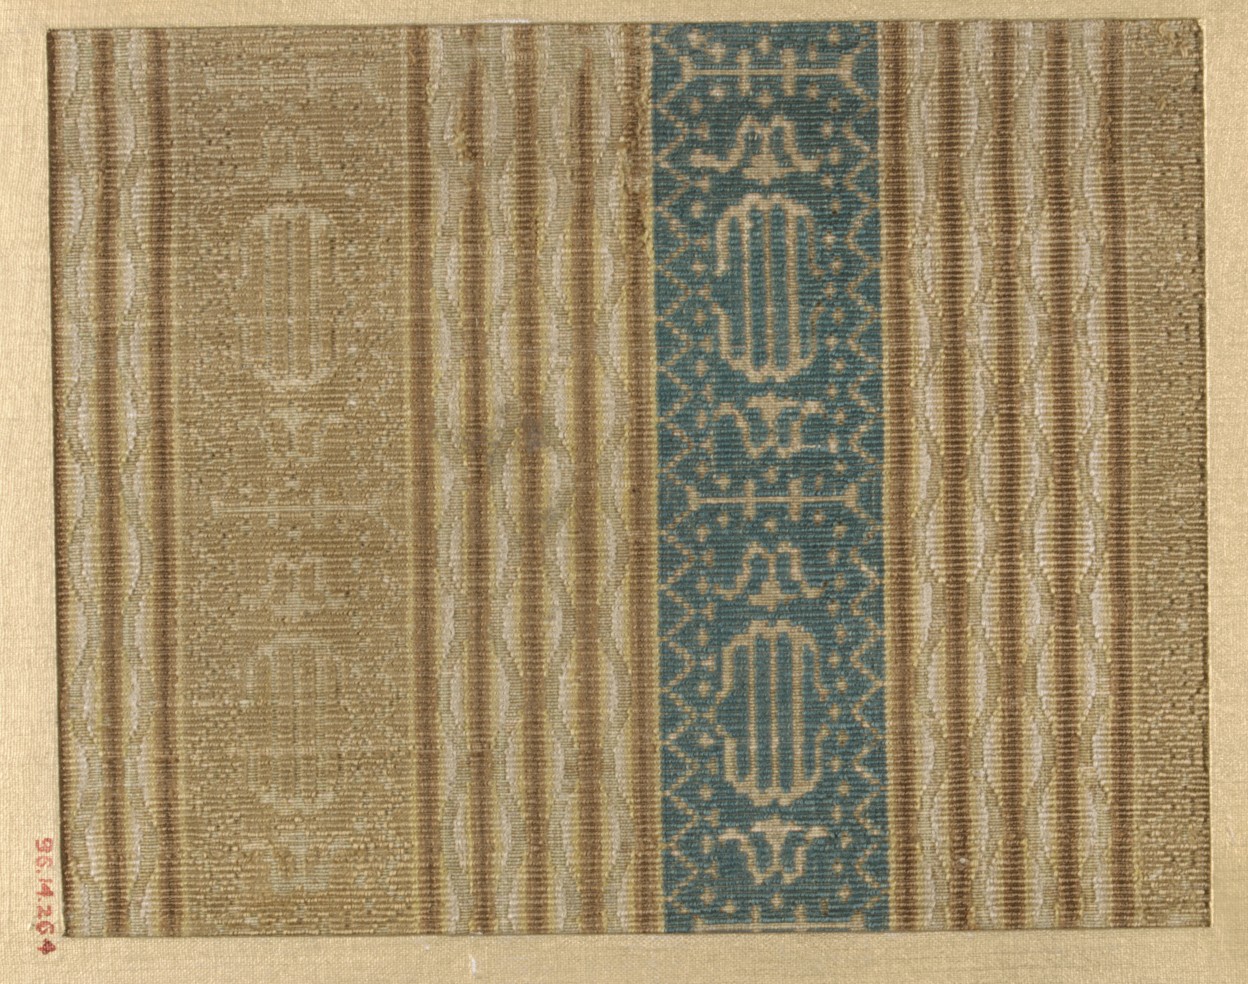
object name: piece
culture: japanese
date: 1701-1900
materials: silk